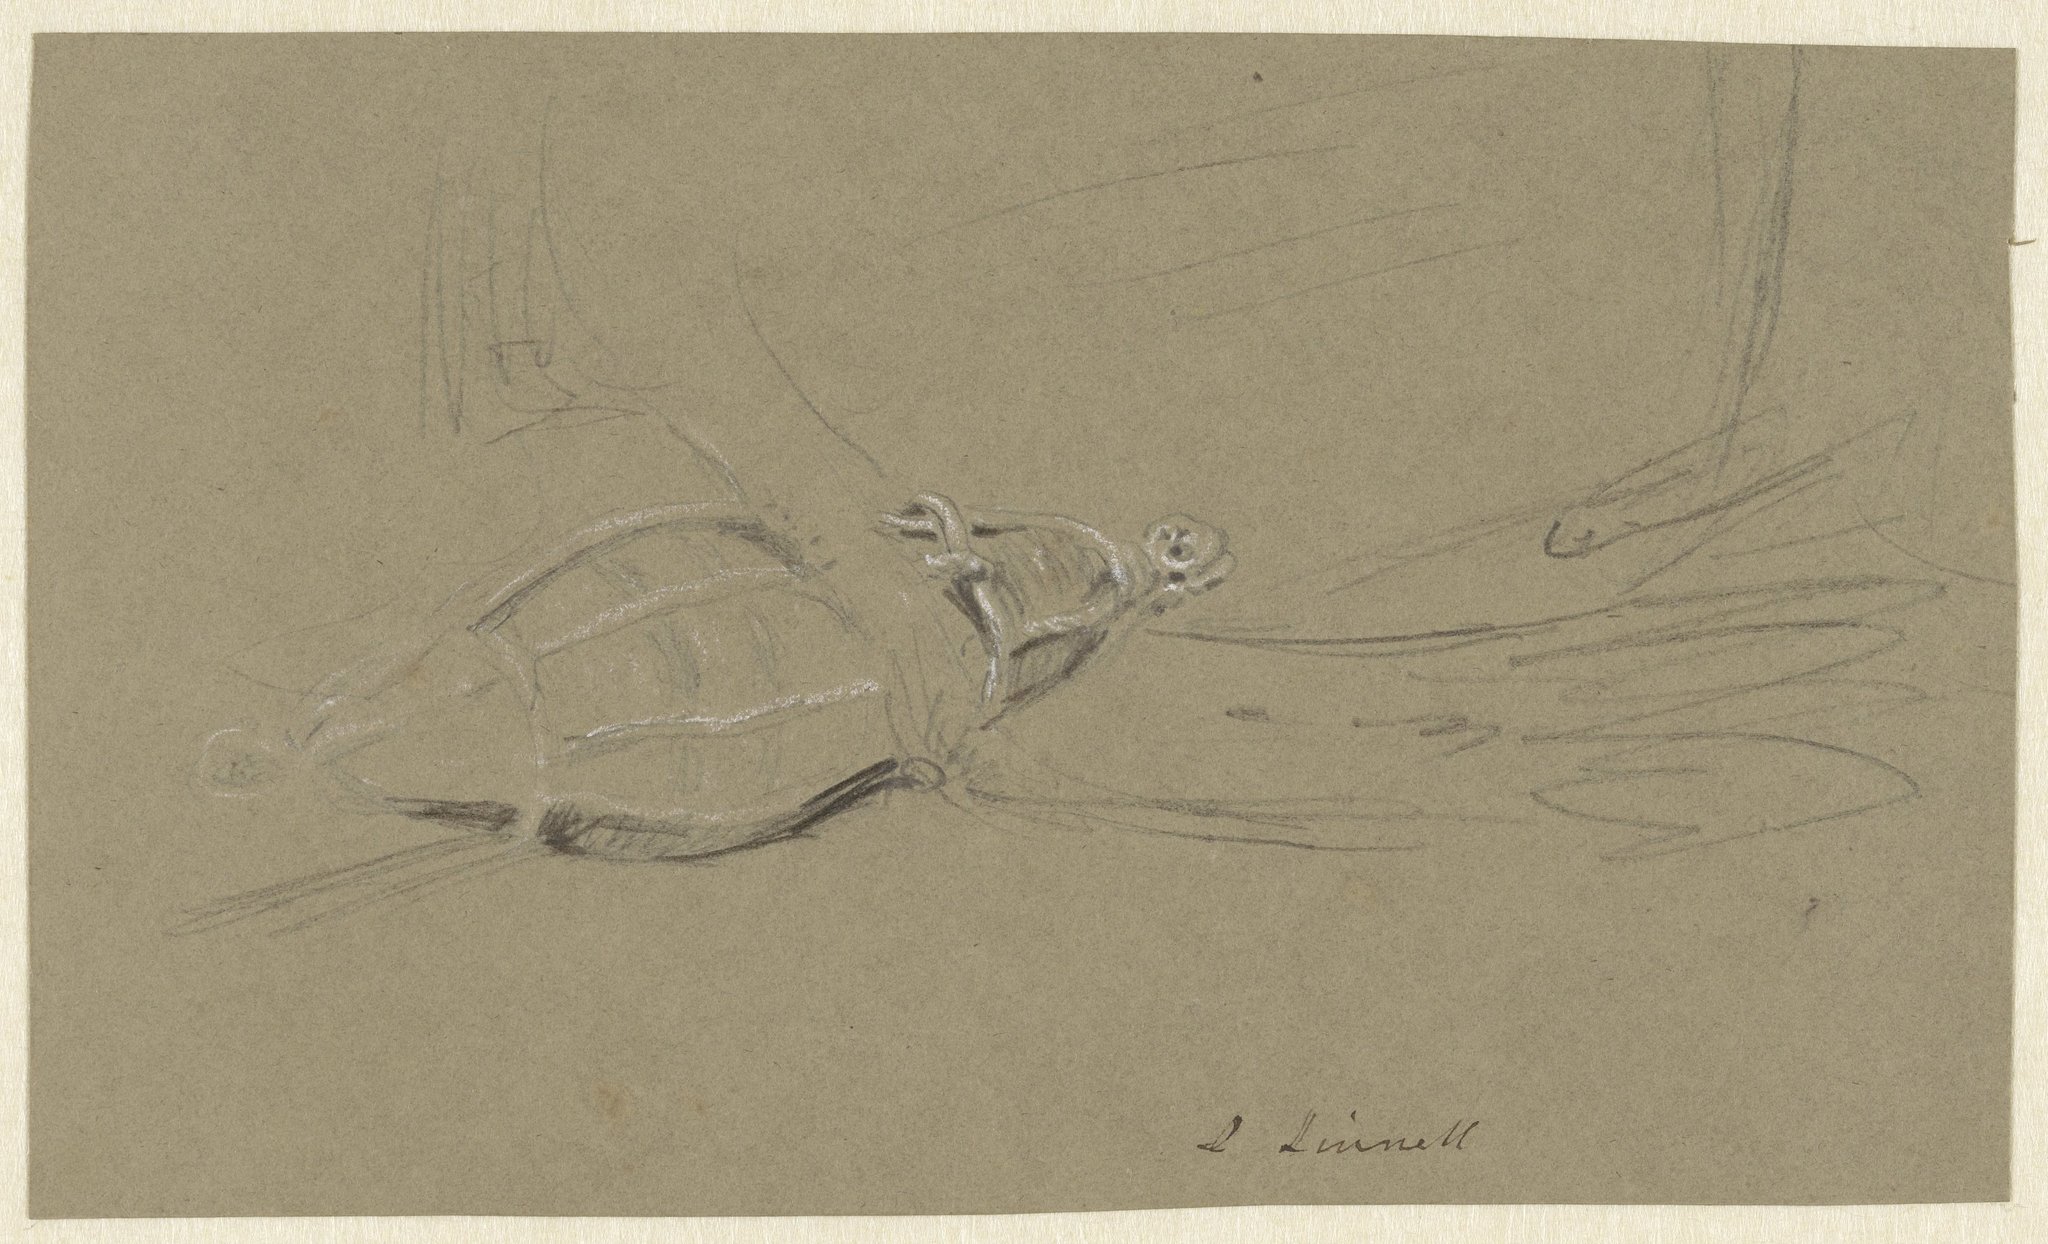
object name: drawing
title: Ankerboei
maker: john linnell (ii)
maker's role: draughtsman, print maker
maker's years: 1792-1882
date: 1802-1882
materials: chalk, paper, pencil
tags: beacon, parts of ship's exterior: anchor